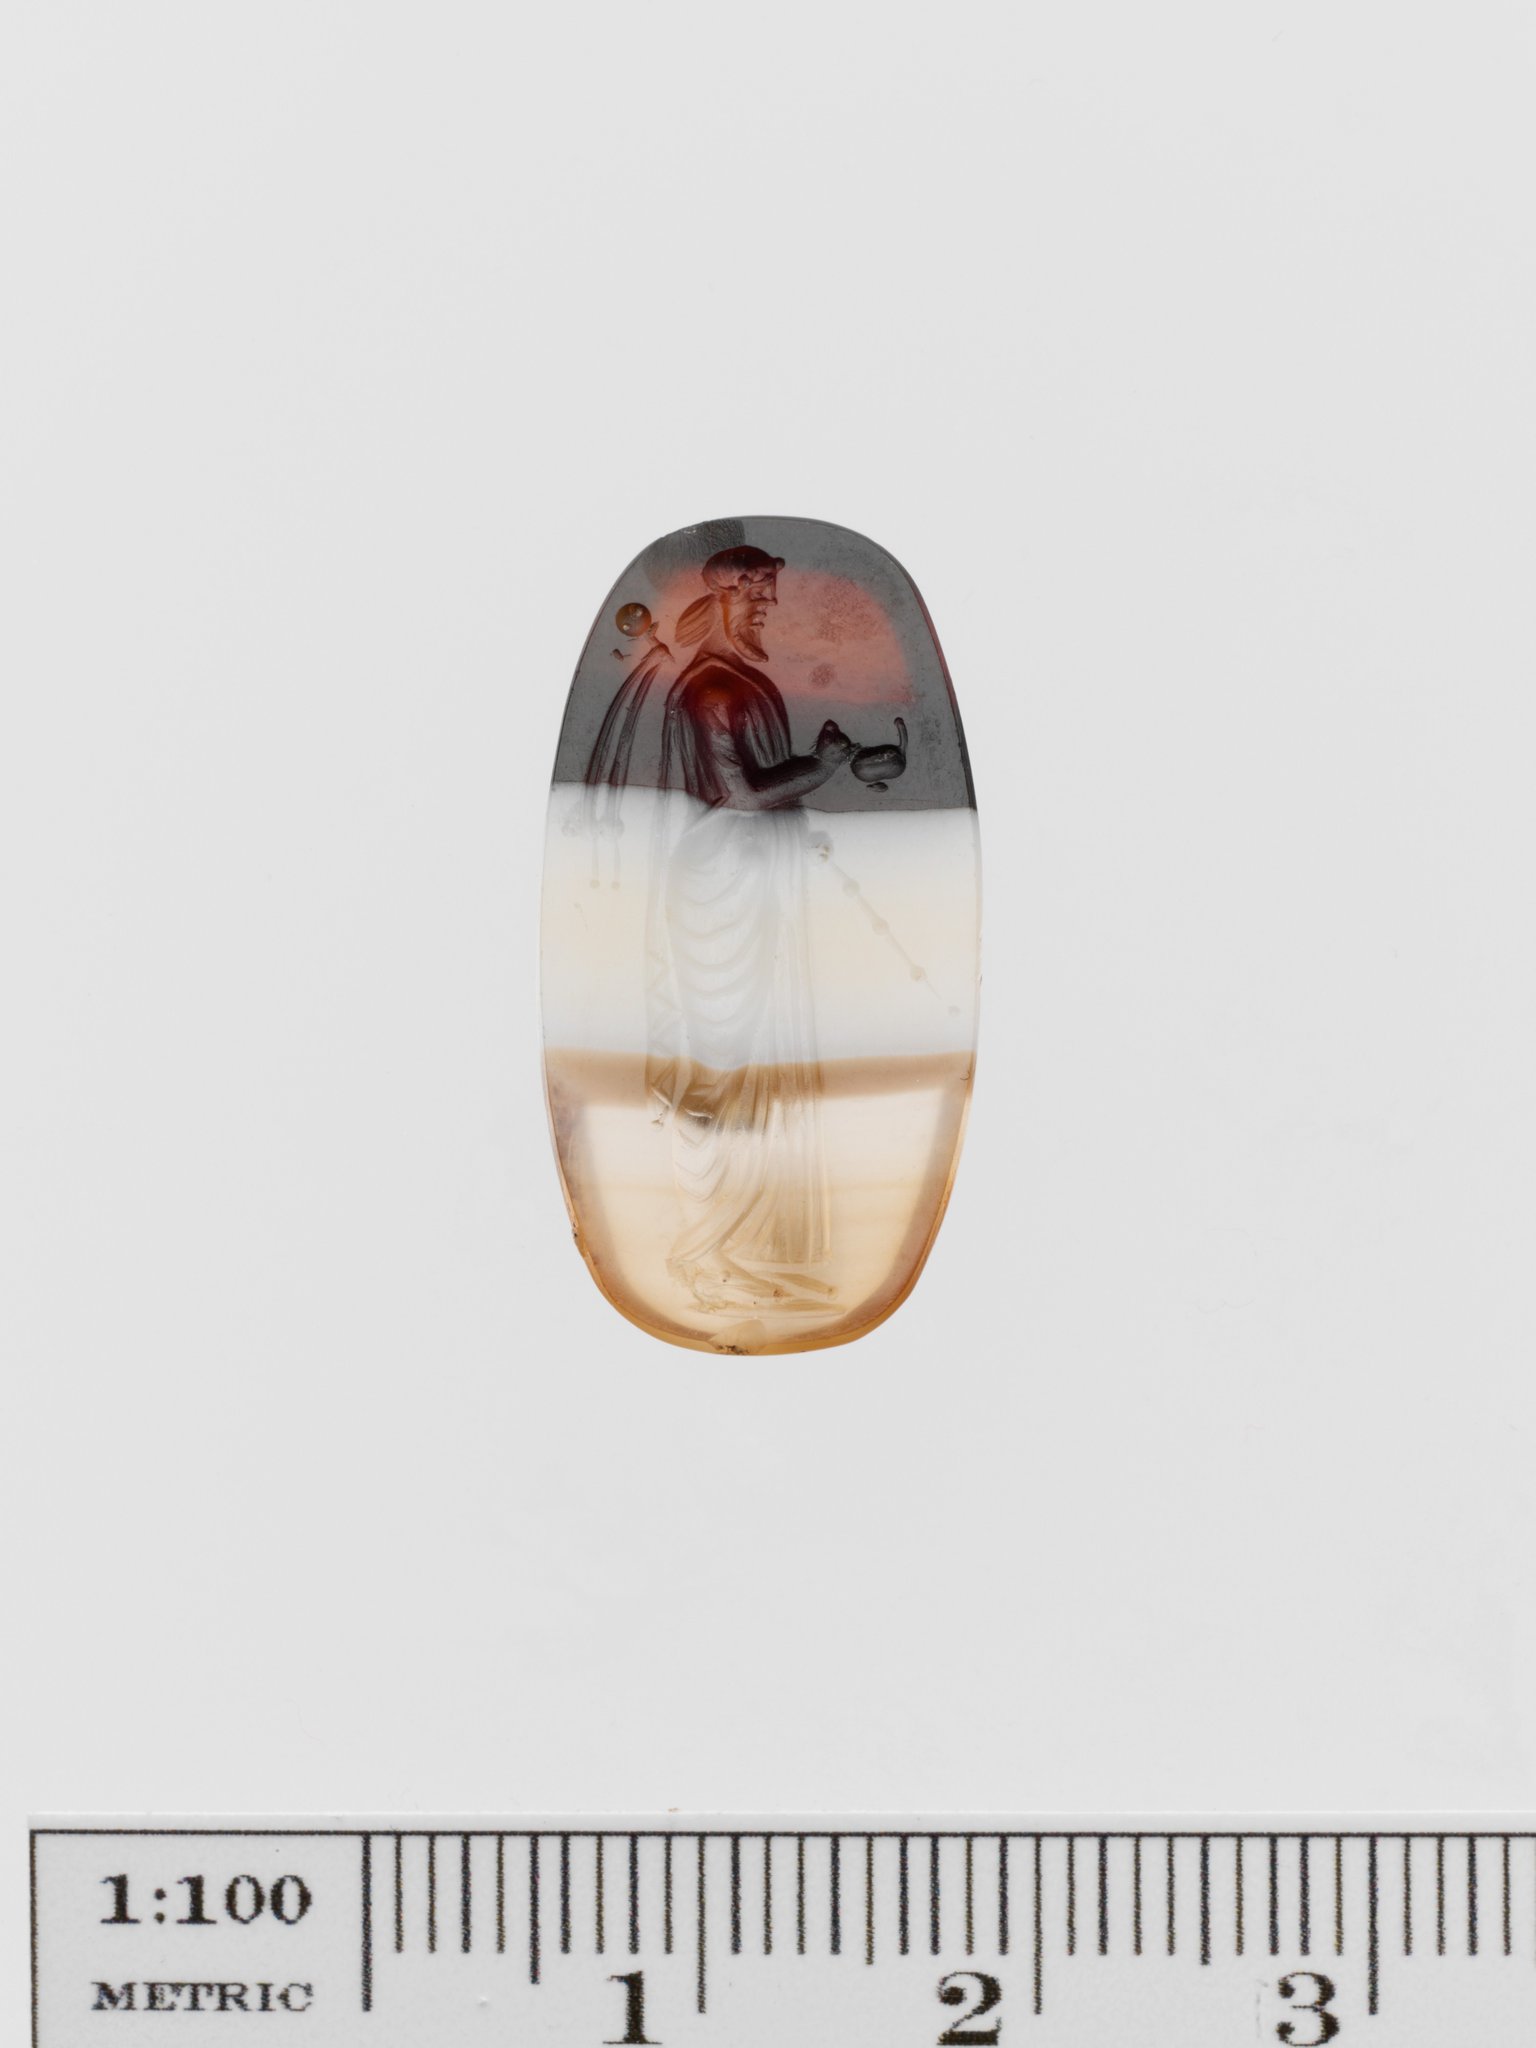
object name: intaglio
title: Banded agate oval gem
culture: greek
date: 334-201 BCE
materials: stone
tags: men,dionysus